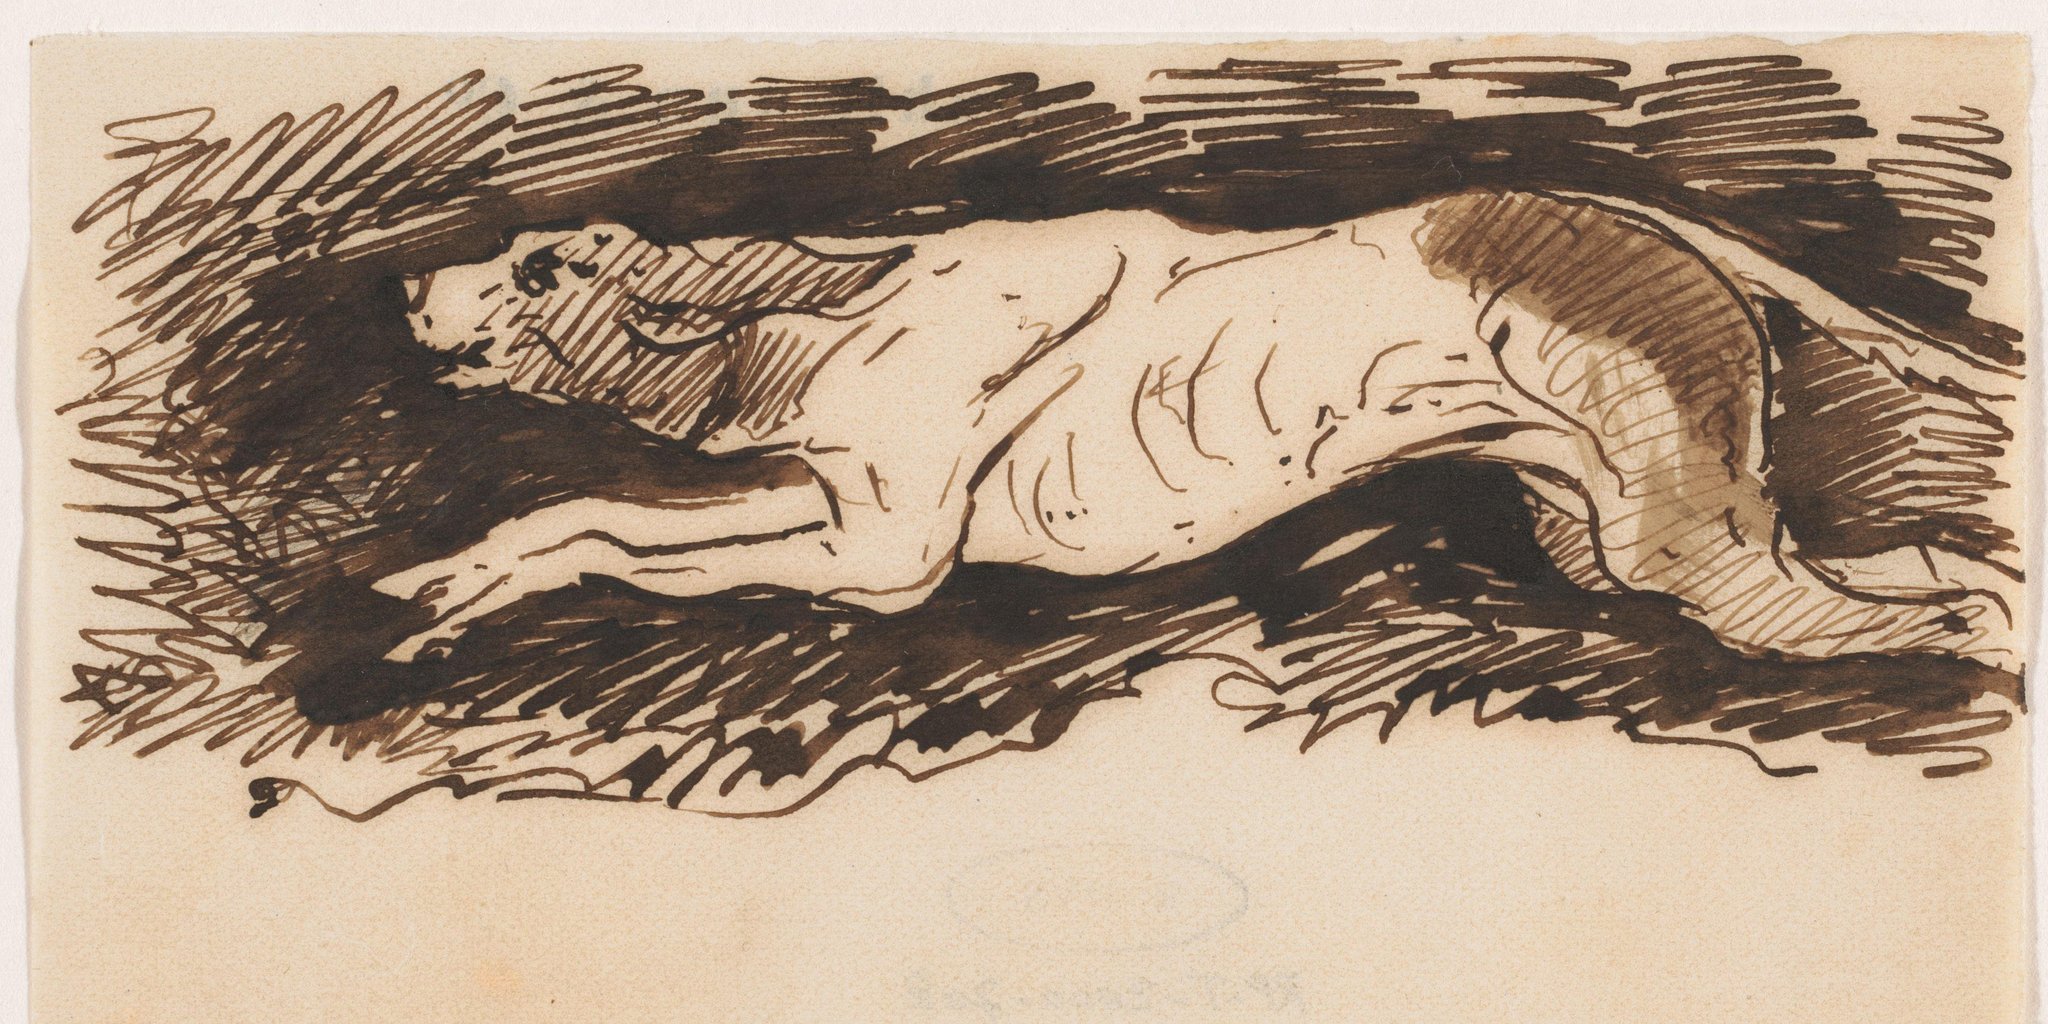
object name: drawing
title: Jachthond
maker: johannes tavenraat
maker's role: draughtsman, painter, print maker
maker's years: 1809-1881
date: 1840-1880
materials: ink, paper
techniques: pen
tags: hunting dogs, dog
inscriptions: collector's mark: Lugt 2228